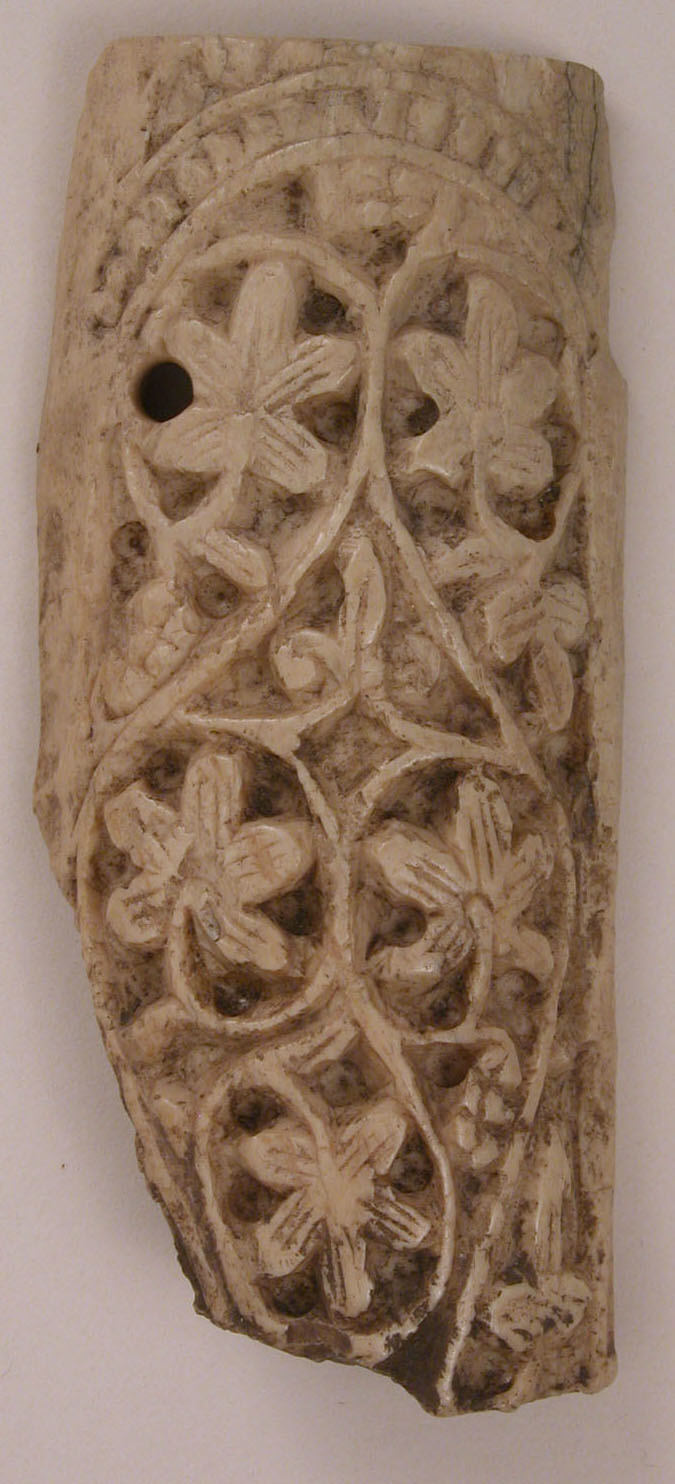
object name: plaque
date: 501-700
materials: bone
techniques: carving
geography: egypt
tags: flowers